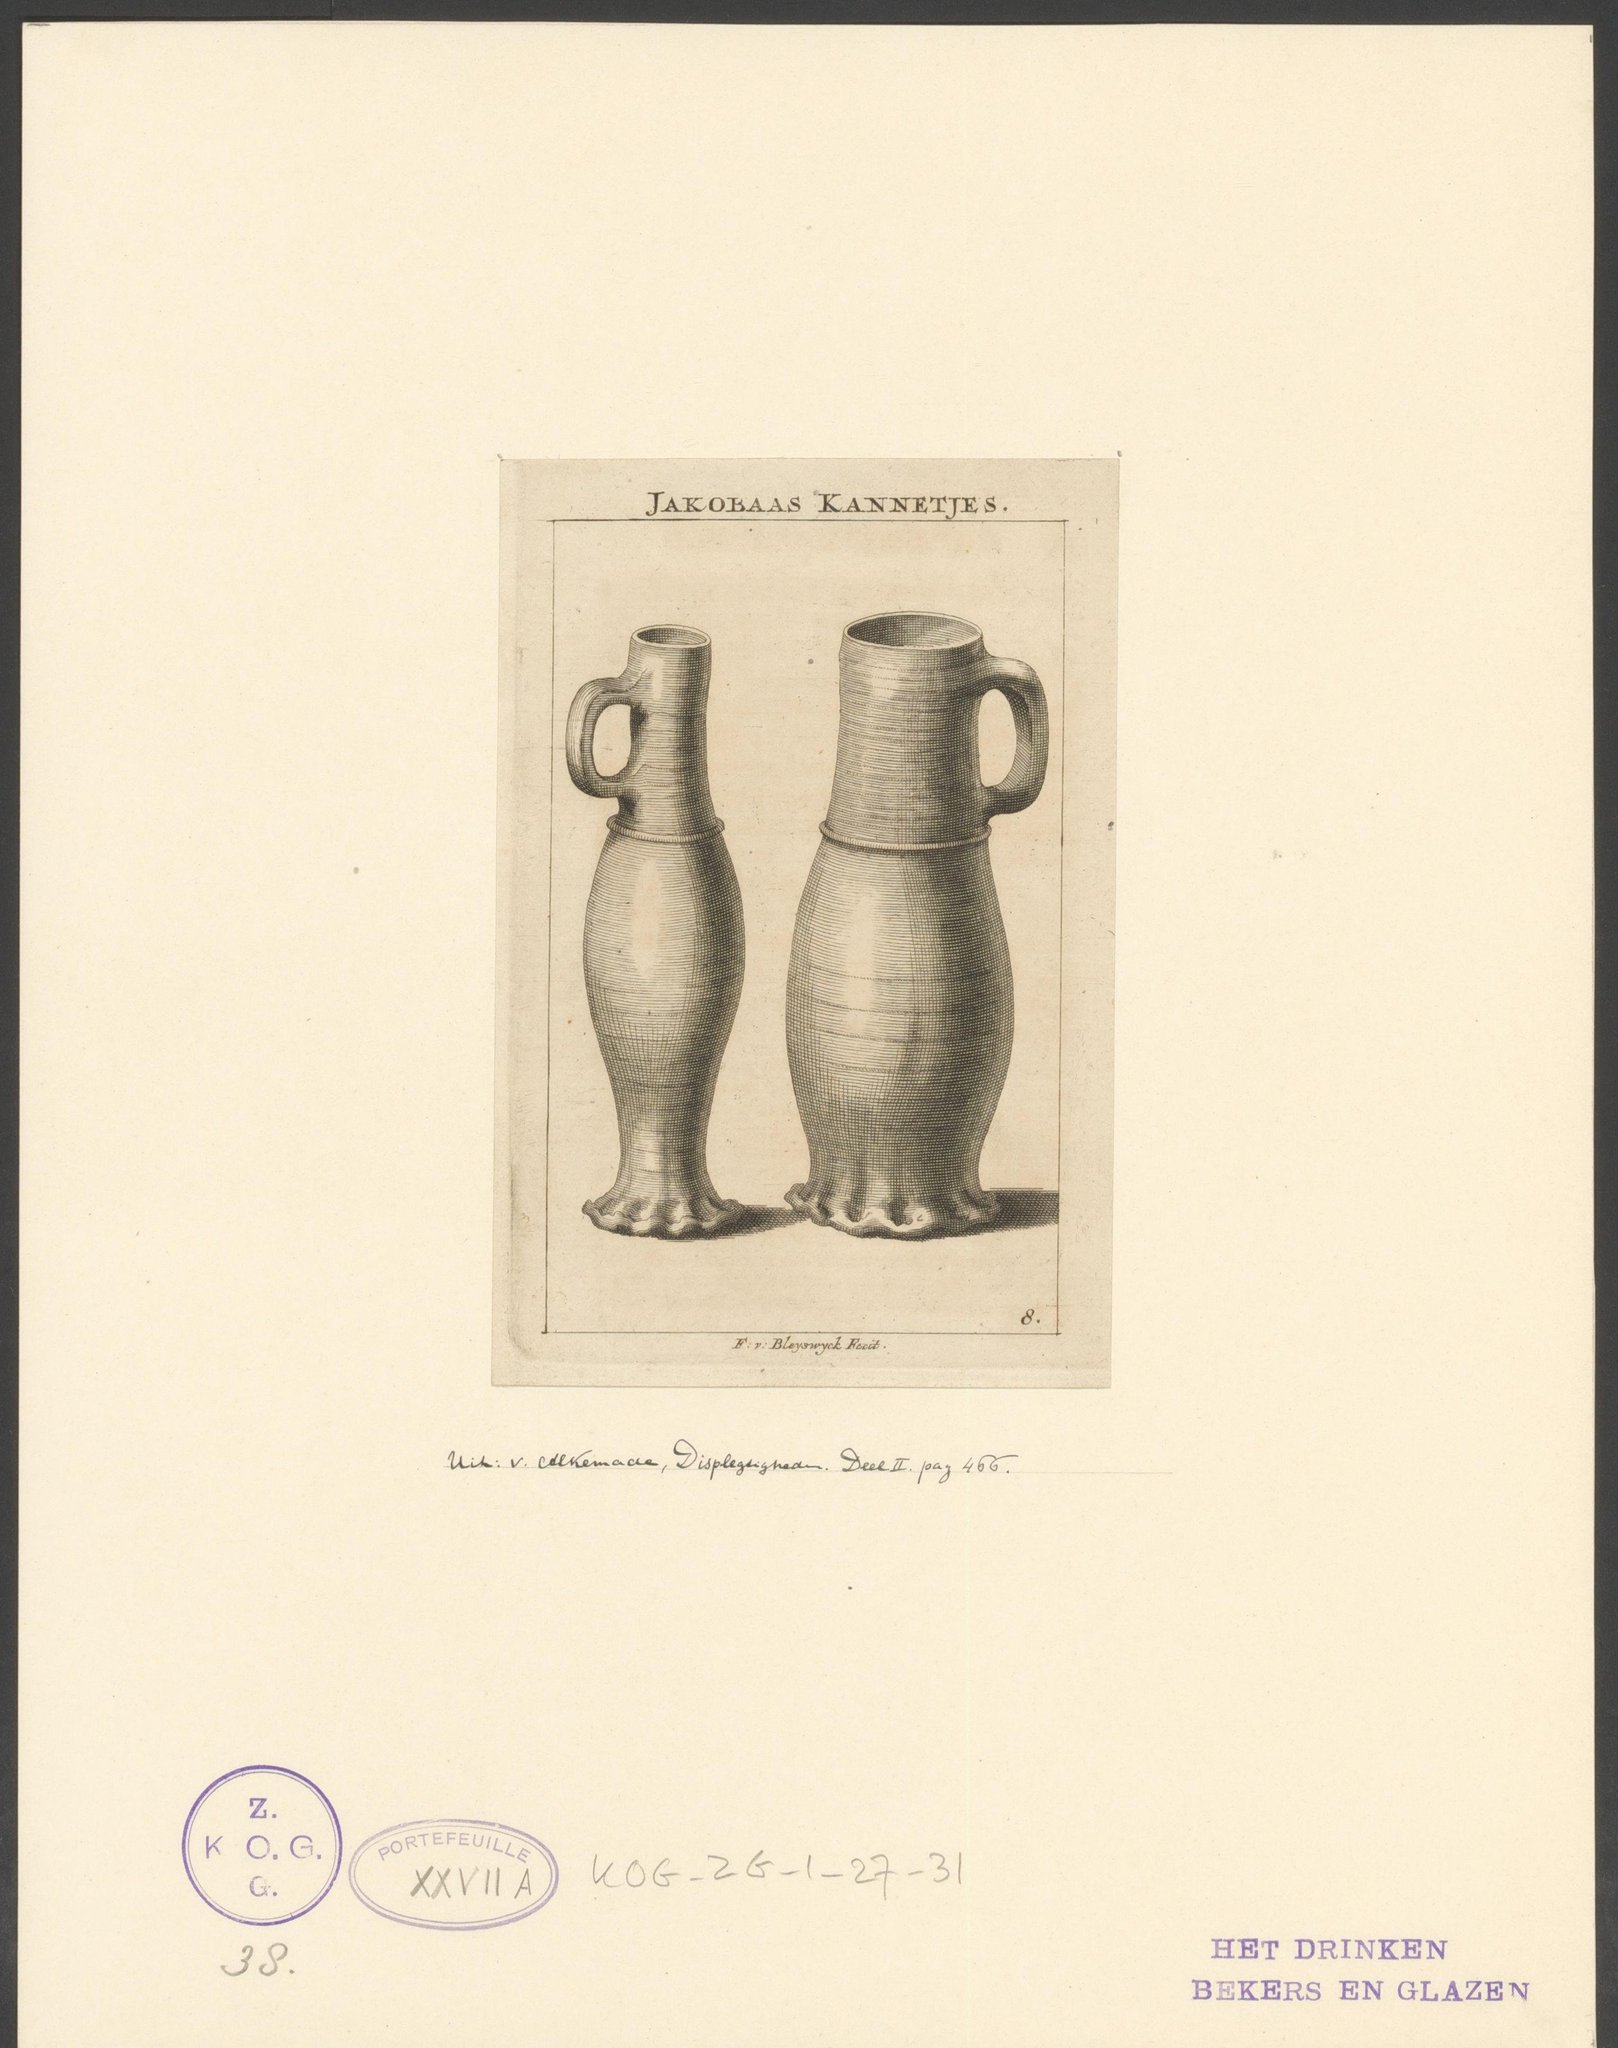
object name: book illustration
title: Jakobaas kannetjes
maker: françois van bleyswijck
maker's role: draughtsman, print maker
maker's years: 1671-1746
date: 1732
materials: paper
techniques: etching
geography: netherlands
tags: jar, jug (used as drinking-vessel), alcoholic drinks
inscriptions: collector's mark, collector's mark: Lugt 1641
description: Gebruikt als illustratie in: Cornelis van Alkemade en Pieter van der Schelling, Nederlands displegtigheden. Rotterdam: Philippus Losel, 3 dln. 1732-1735, dl. II (1732), t.o. p. 467.